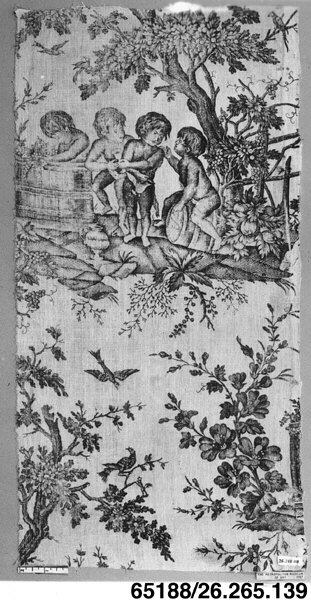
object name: furnishing textile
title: "Apotheosis of Necker"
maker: gorgerat frères et cie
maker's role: manufactory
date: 1788-1791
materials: cotton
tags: birds,boys,flowers,trees